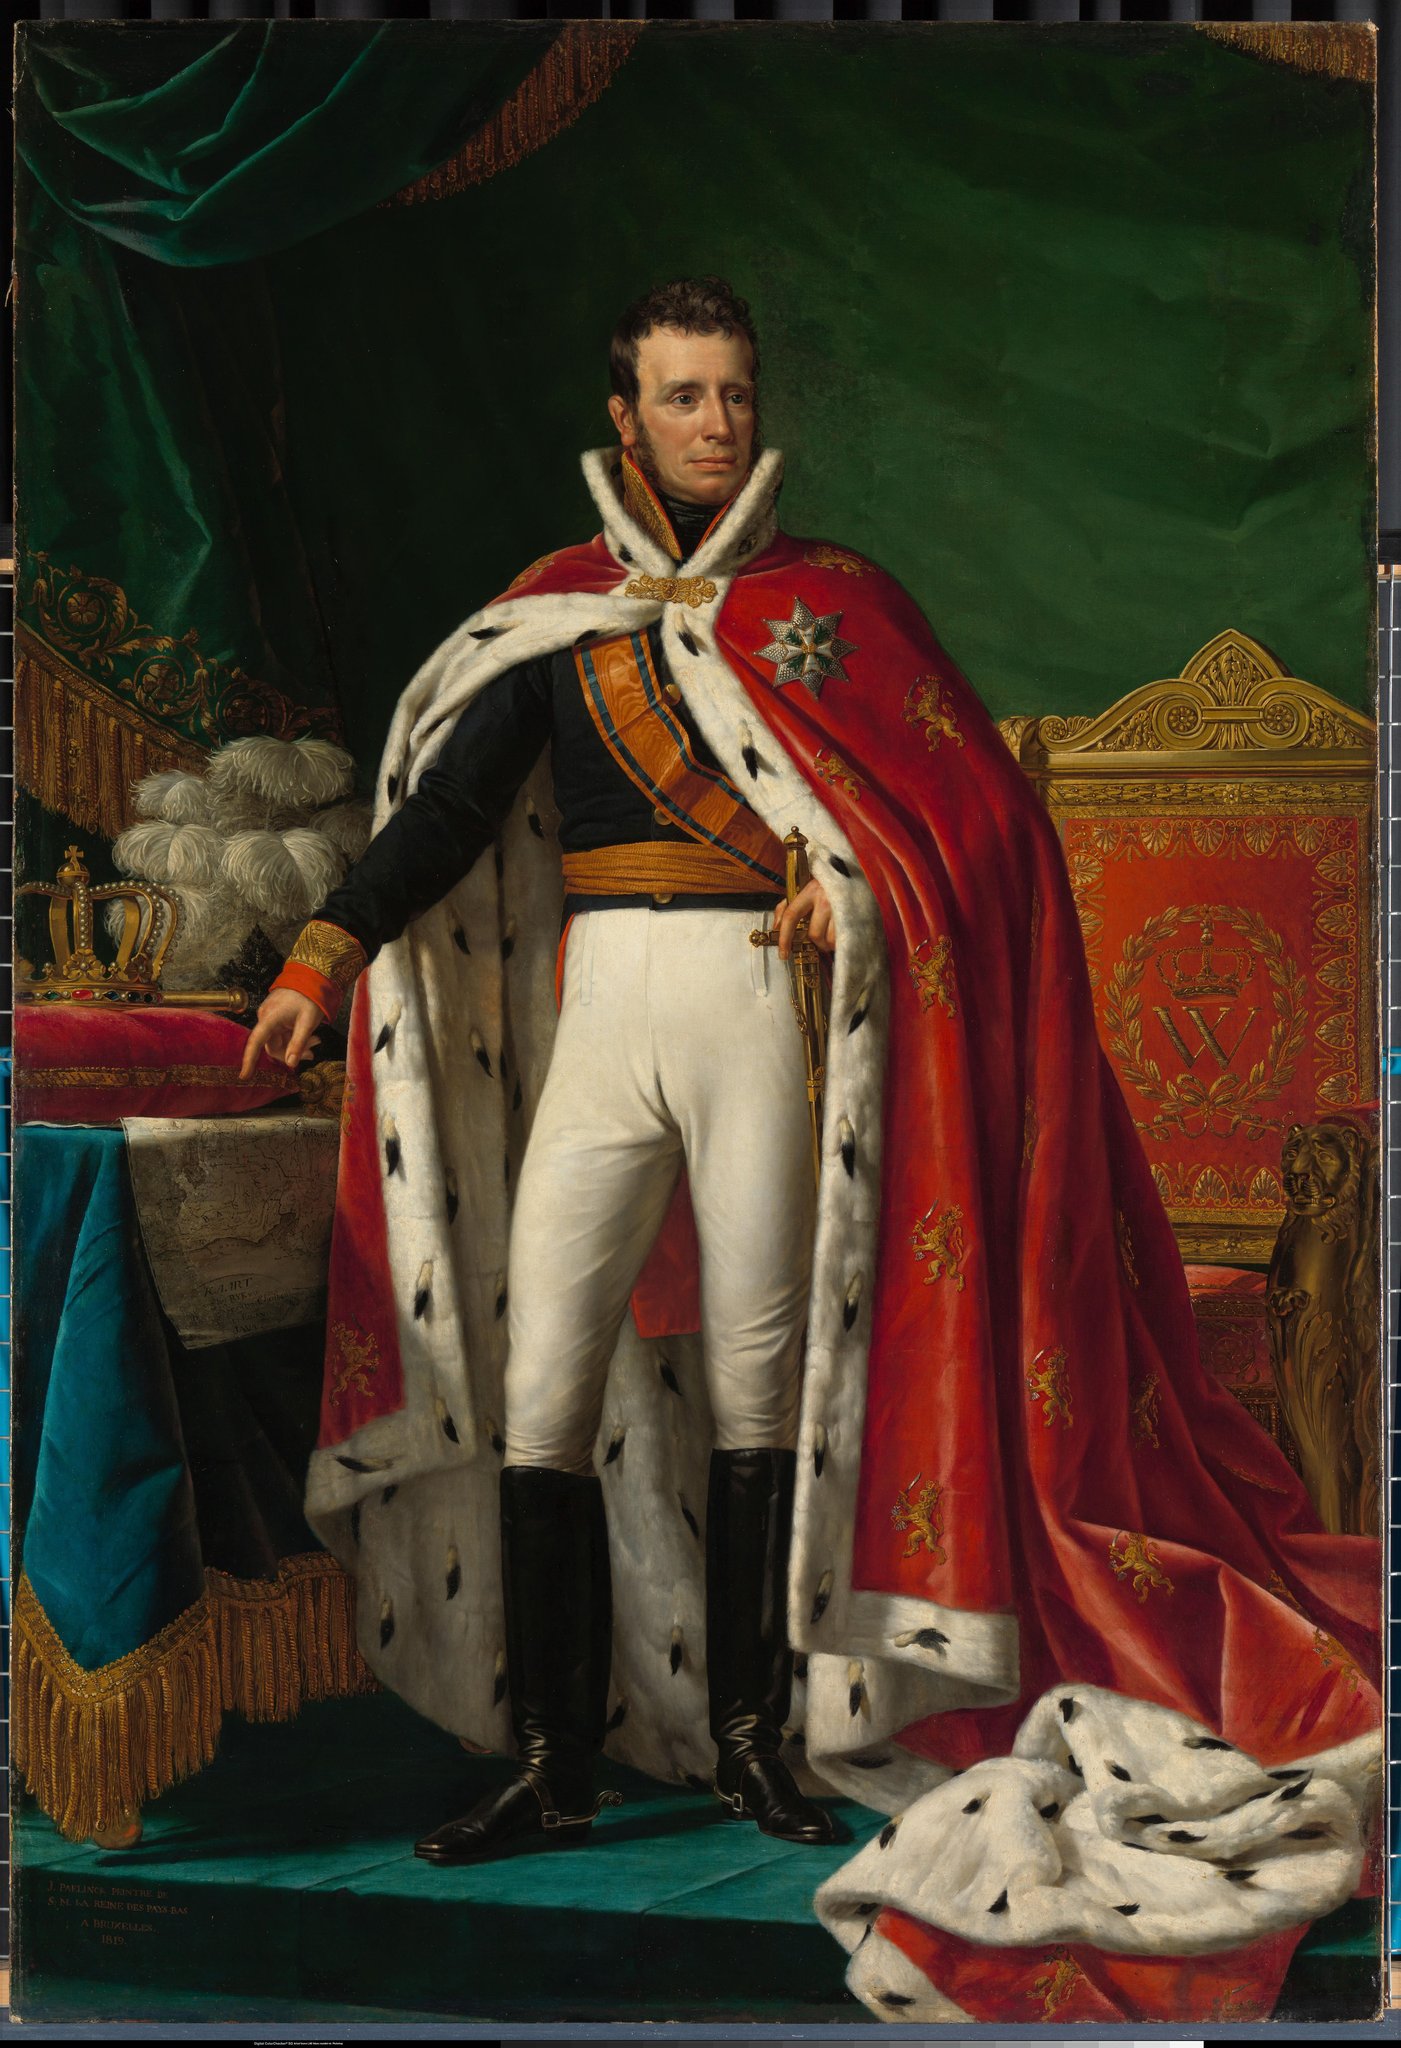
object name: painting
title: Portrait of William I, King of the Netherlands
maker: joseph paelinck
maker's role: painter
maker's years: 1781-1839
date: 1819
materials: canvas, oil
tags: berlin, william i of the netherlands, crown (symbol of sovereignty), historical persons, throne, king, batavia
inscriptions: inscription: ‘Kaart van het Ryk van Bantam, Jacatra & Cheribon op het eylant Java’, signature and date: ‘J. Paelinck Peintre de S.M. La Reine des Pays Bas à Bruxelles. 1819’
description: After the Battle of Waterloo, William Frederick, prince of Orange-Nassau and son of Stadholder William V, was inaugurated as King William I in 1815. Here he wears the full-dress uniform of a general, with the royal ermine cloak over it. He points to a map of Java in what was then the Dutch East Indies, where the portrait came to hang in the governor’s palace in 1821.